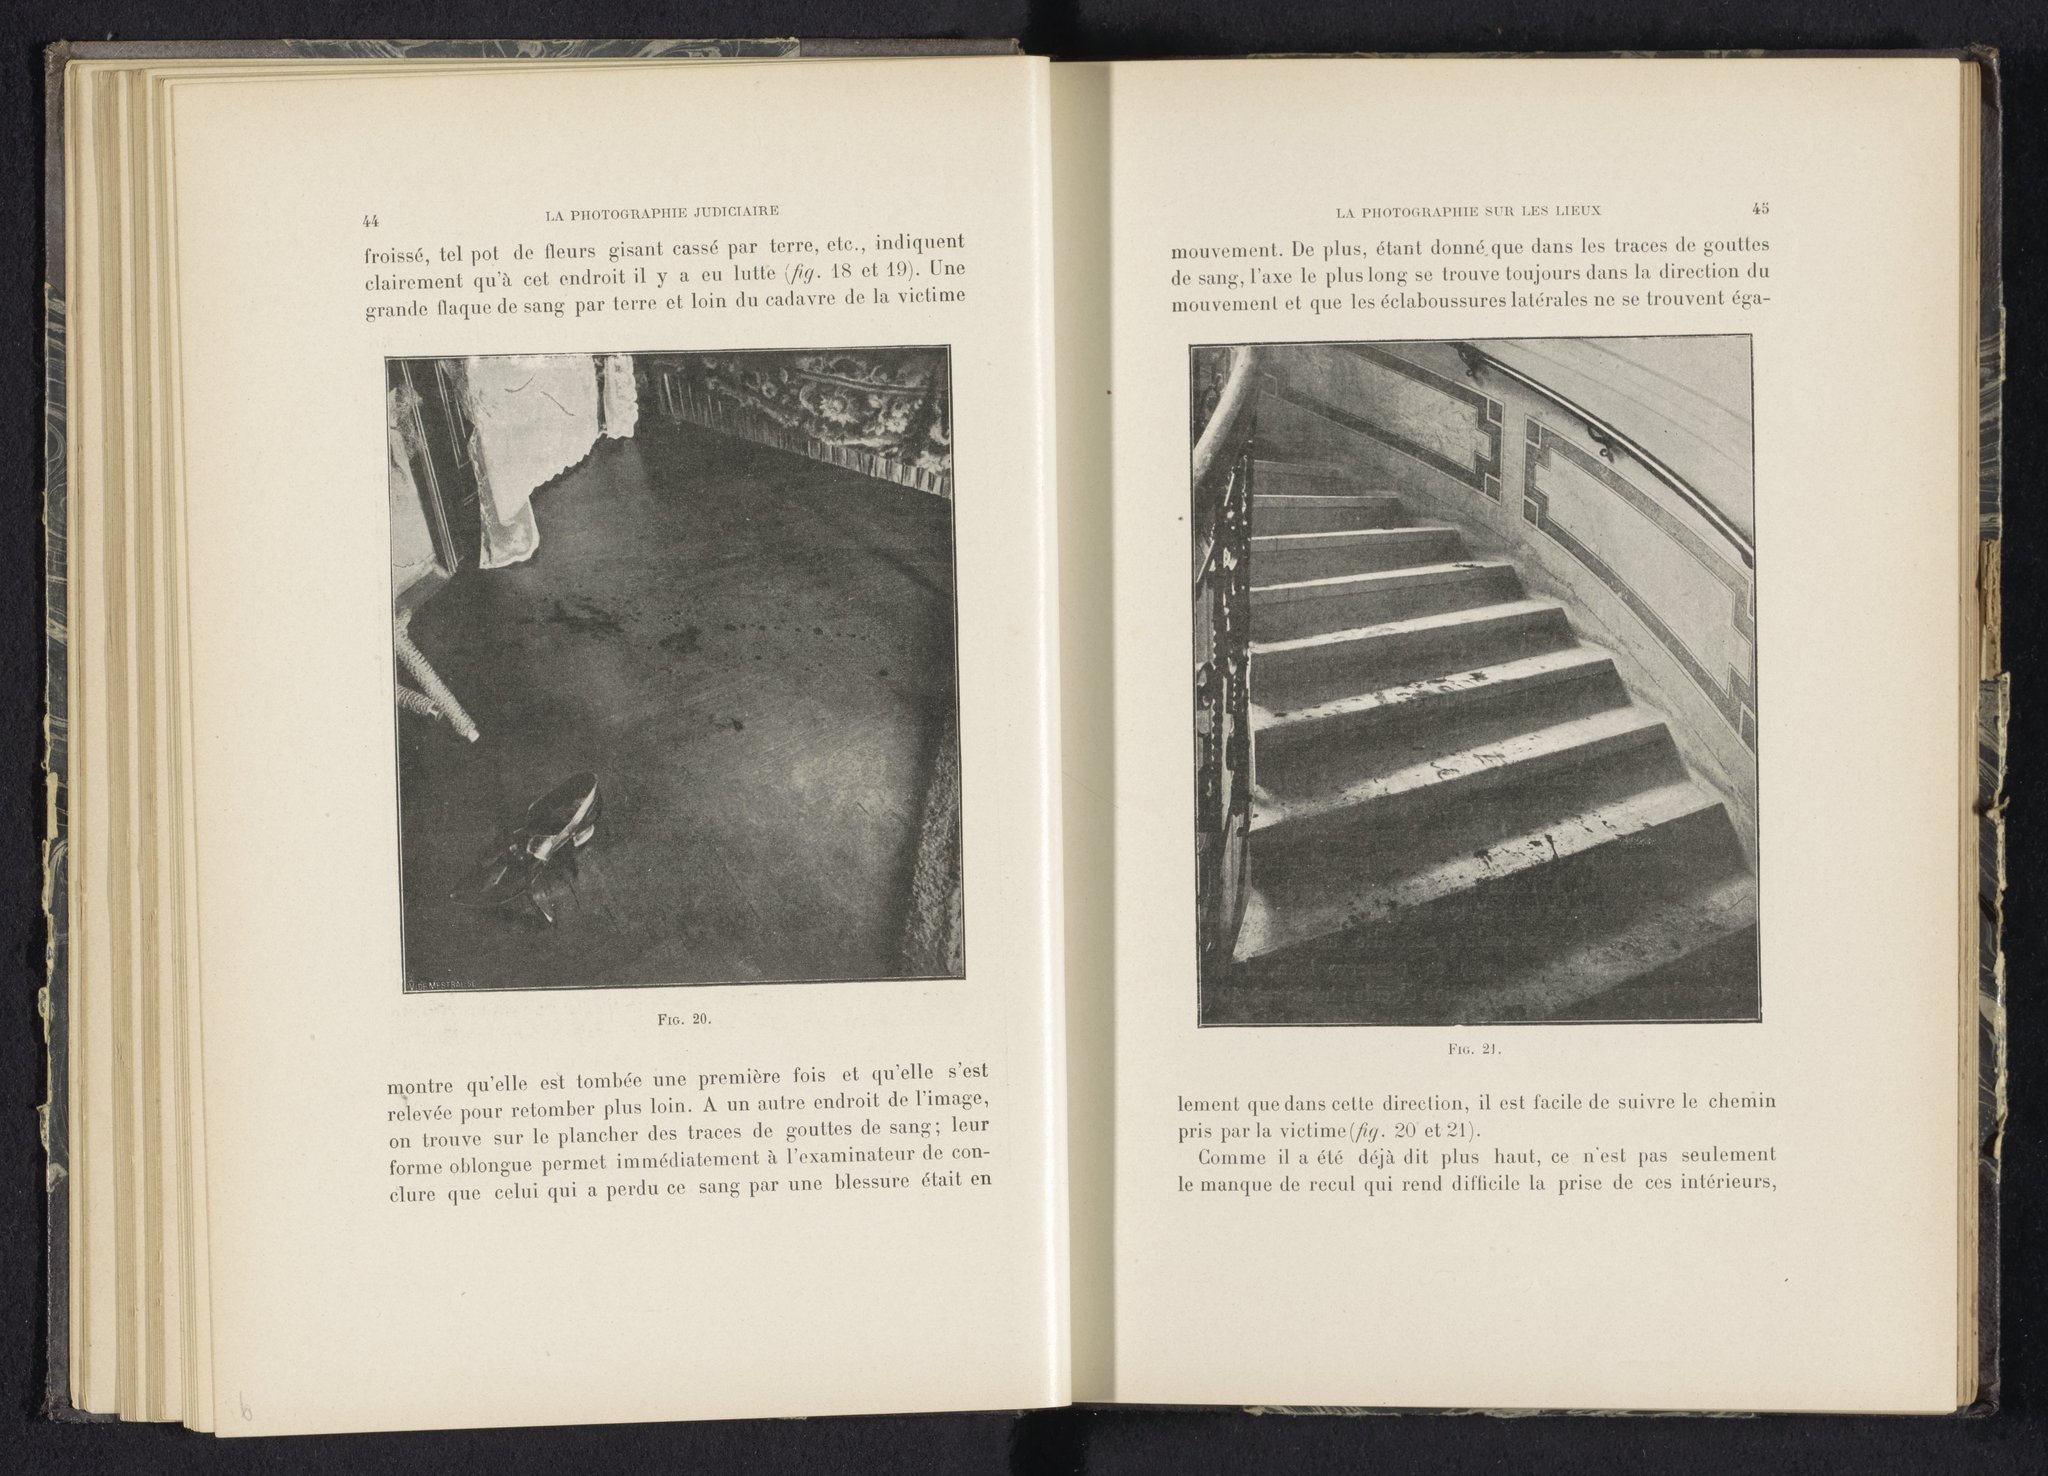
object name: photomechanical print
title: Plaats delict met bloedspatten op een trap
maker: Anonymous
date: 1893-1903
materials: paper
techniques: autotype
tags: blood, visiting the scene of the crime, staircase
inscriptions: number: ‘Fig. 21.’